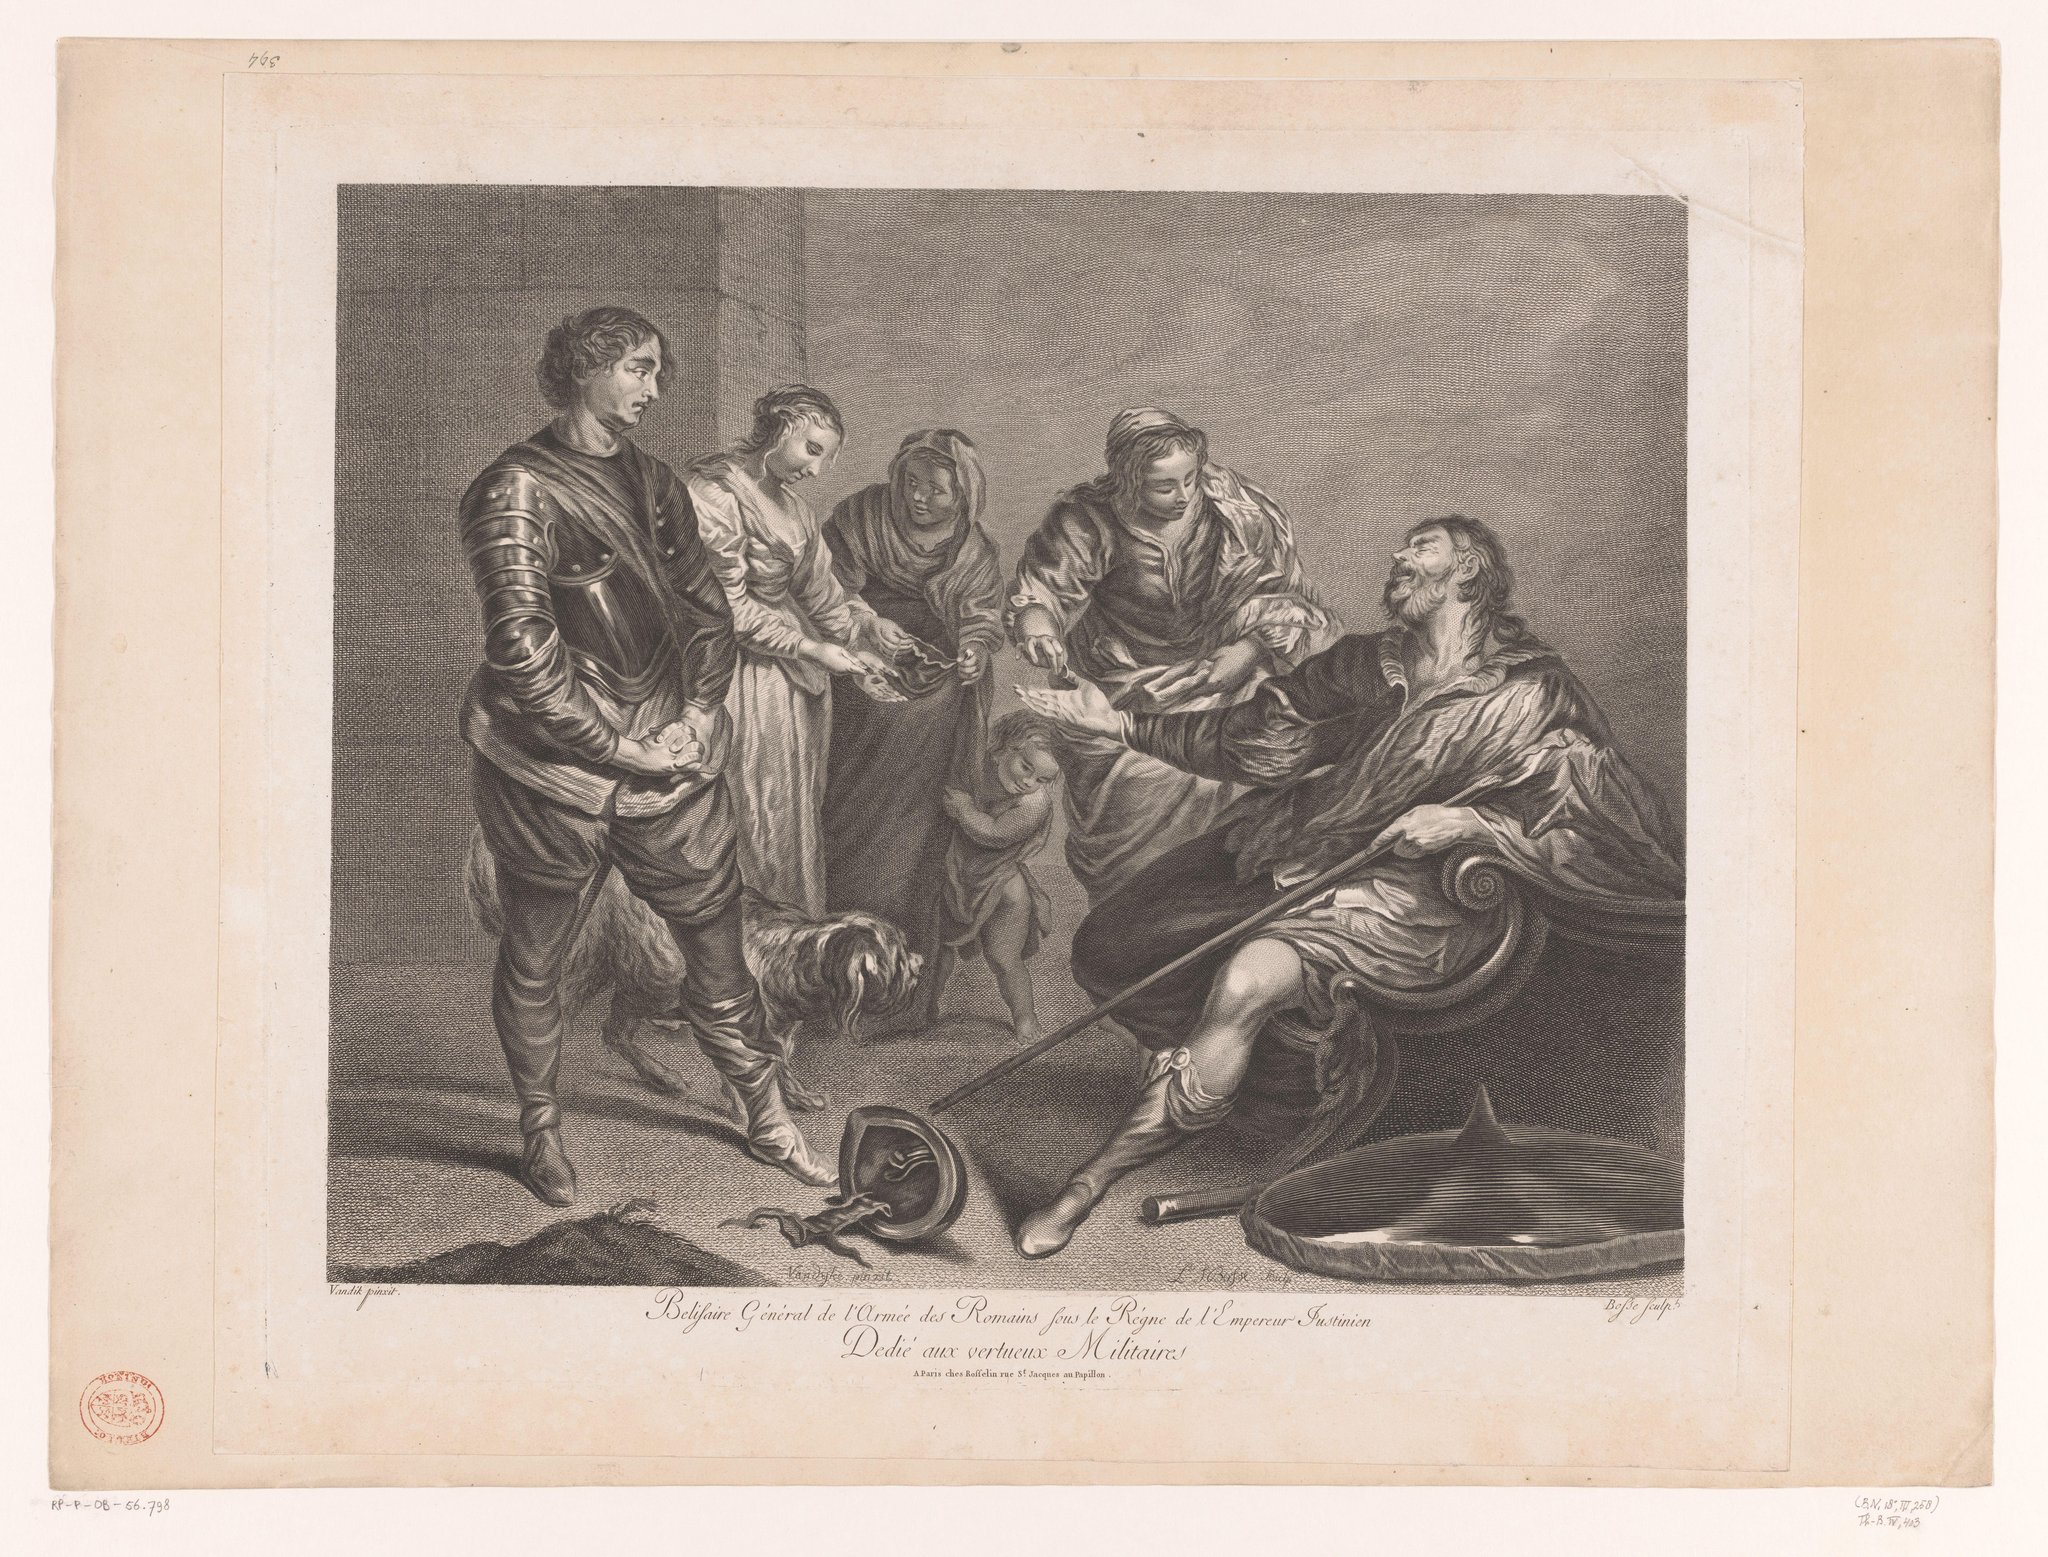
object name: print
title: Belisarius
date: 1767-1777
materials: paper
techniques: engraving, etching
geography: paris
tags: blind, blindness, recognizing, belisarius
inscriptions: collector's mark: Lugt 240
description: De blinde Belisarius zit op een stoel en houdt zijn rechterhand op voor een aalmoes. Voor hem staan drie vrouwen met een kind en een hond. Een soldaat kijkt toe.